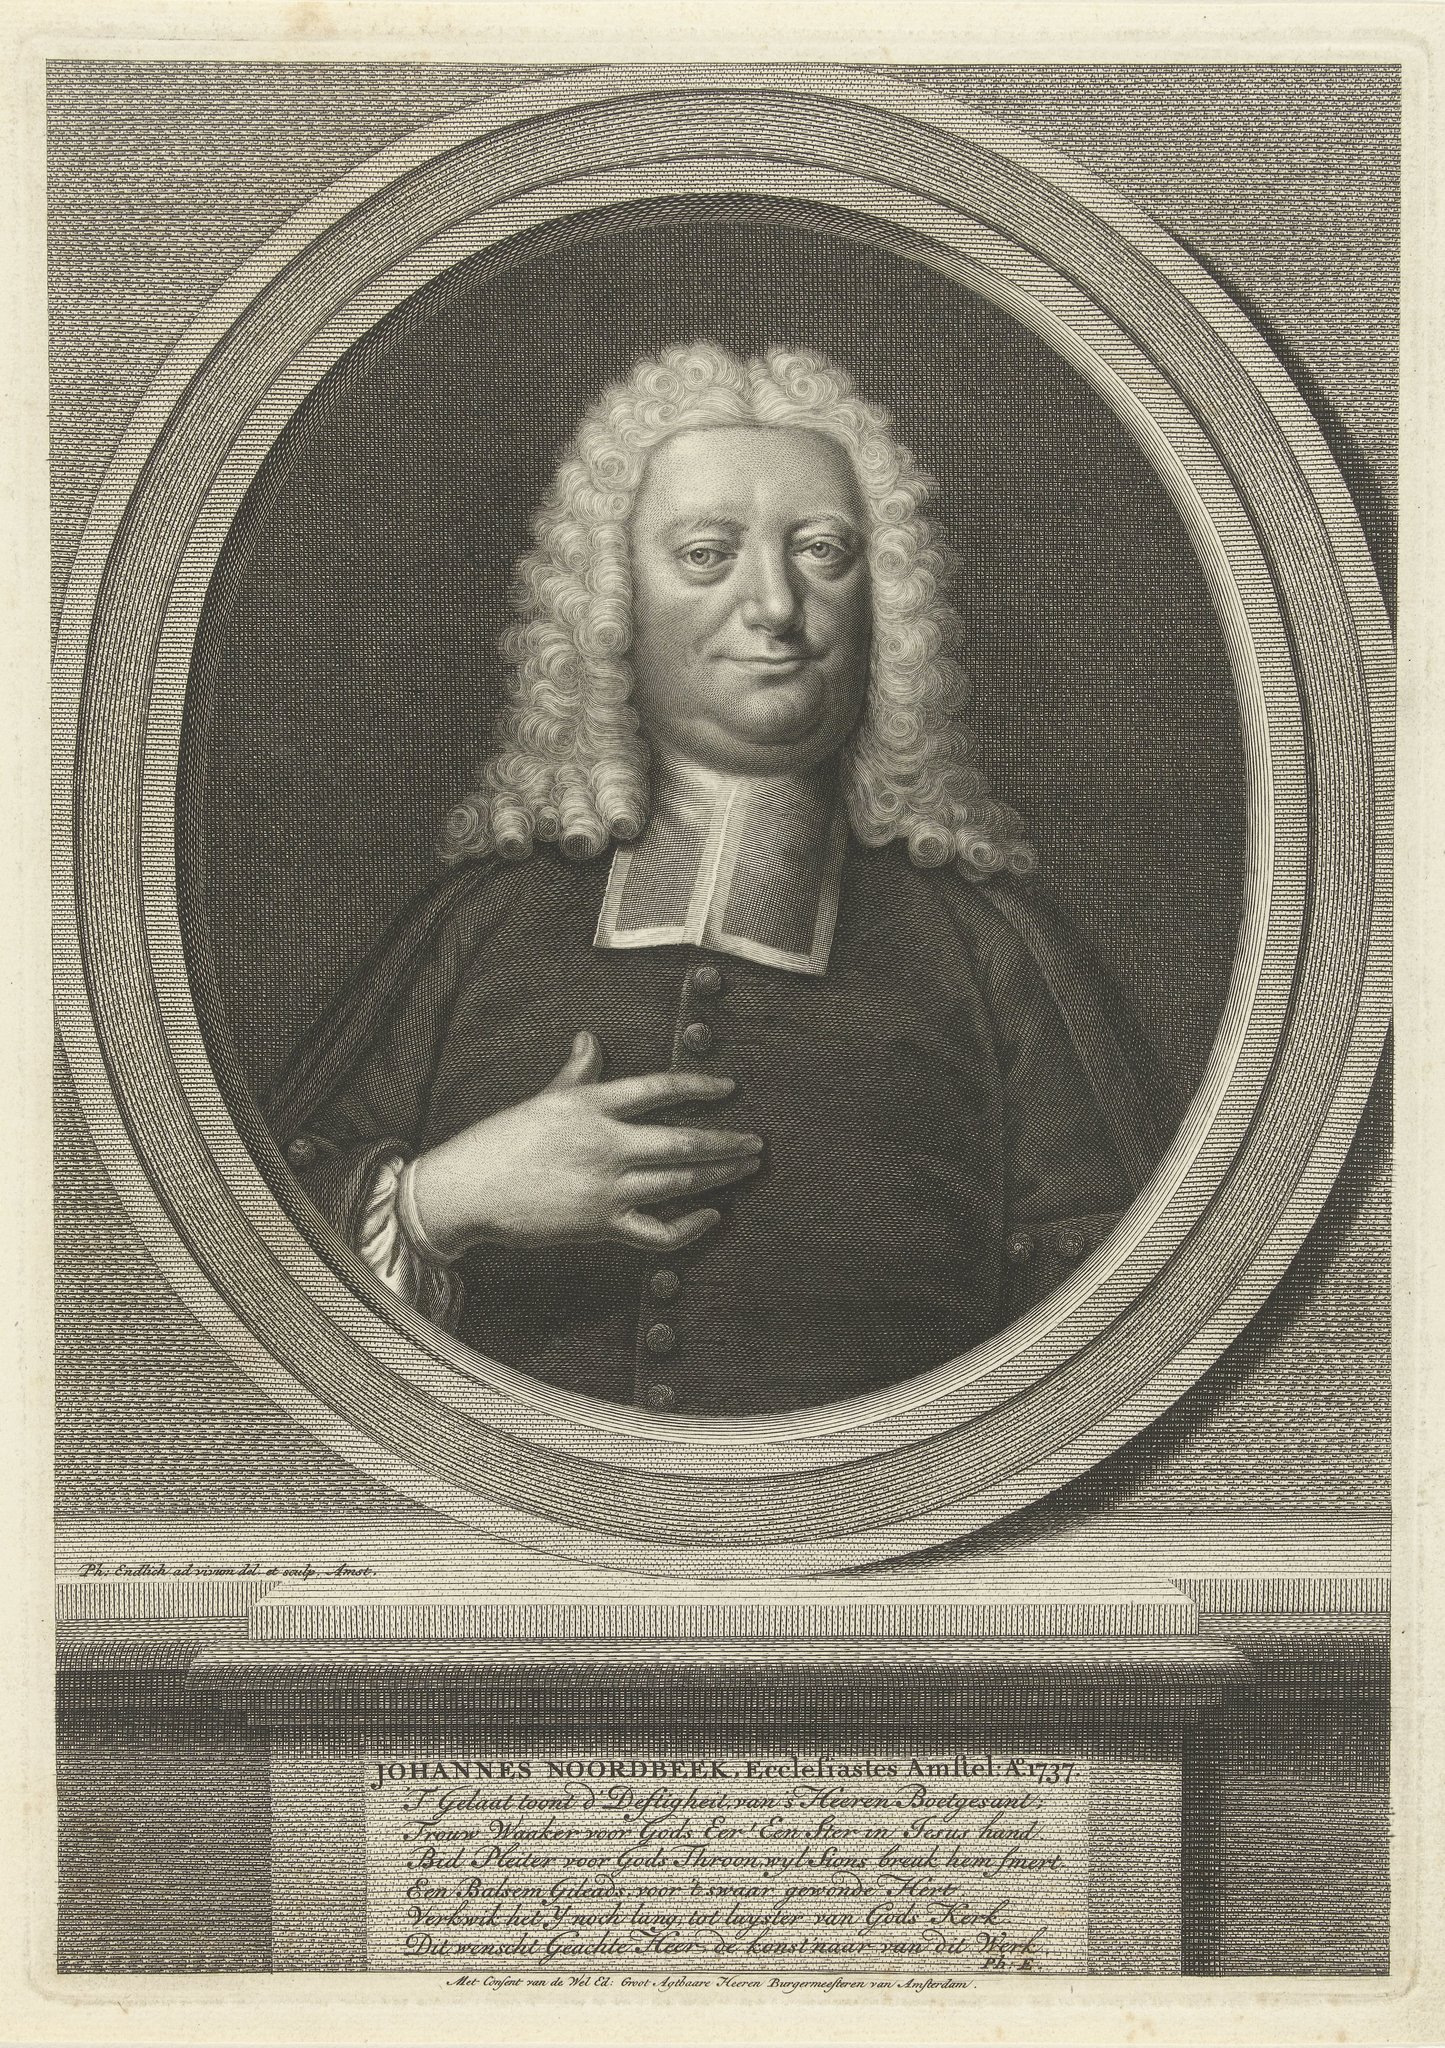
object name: print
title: Portret van Johannes Noordbeek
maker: philippus endlich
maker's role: draughtsman, print maker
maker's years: 1700-1748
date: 1737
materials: paper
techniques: engraving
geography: amsterdam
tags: predikant, johannes noordbeek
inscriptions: collector's mark: Lugt 2228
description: Portret van de Amsterdamse predikant Johannes Noordbeek (1683-1749), afgebeeld met hand op de borst, in ovale omlijsting. Onder de lijst een console waarop een Nederlands vers van zes regels.